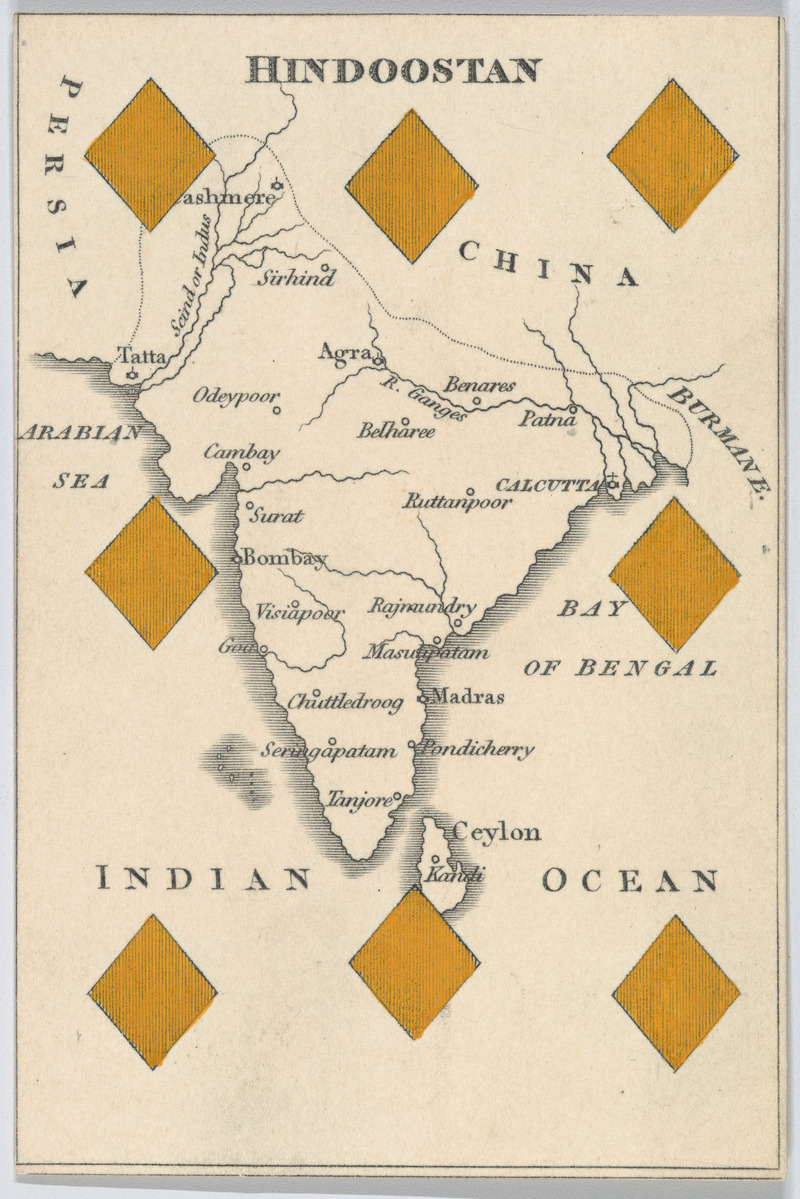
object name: print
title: Hindoostan in Asia, from "Court Game of Geography"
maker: william and henry rock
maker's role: publisher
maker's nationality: british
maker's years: 1821-1884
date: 1838-1855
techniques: engraving, hand coloring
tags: playing cards,maps